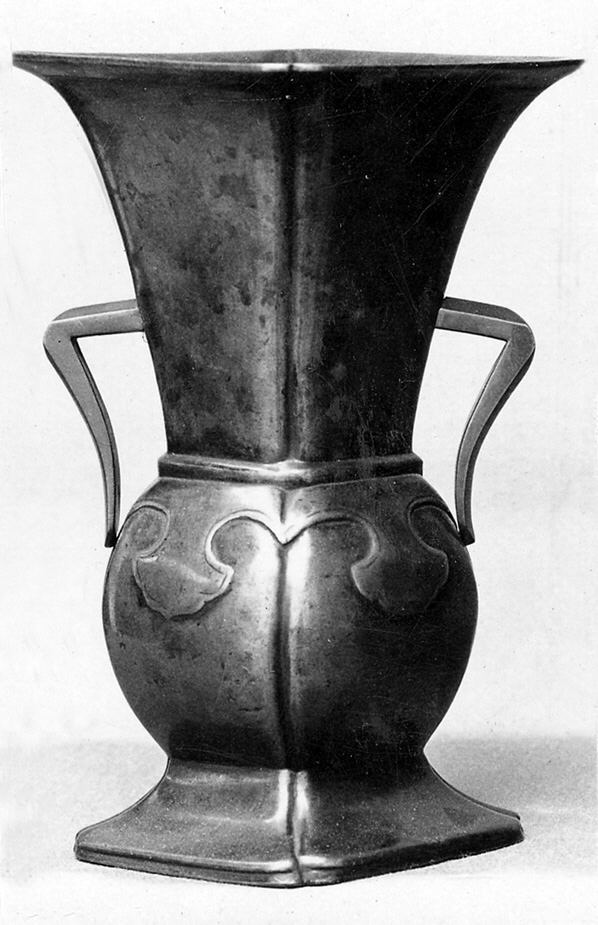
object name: vase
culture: japanese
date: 1801-1900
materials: bronze